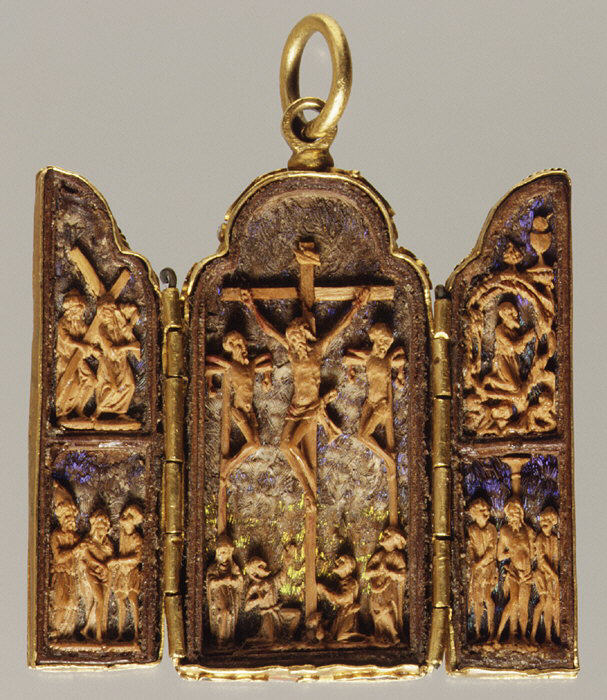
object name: triptych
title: Scenes of the Passion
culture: mexican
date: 1501-1600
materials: wood, enamel, feather, gold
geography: spain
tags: christ,bearing the cross,crucifixion